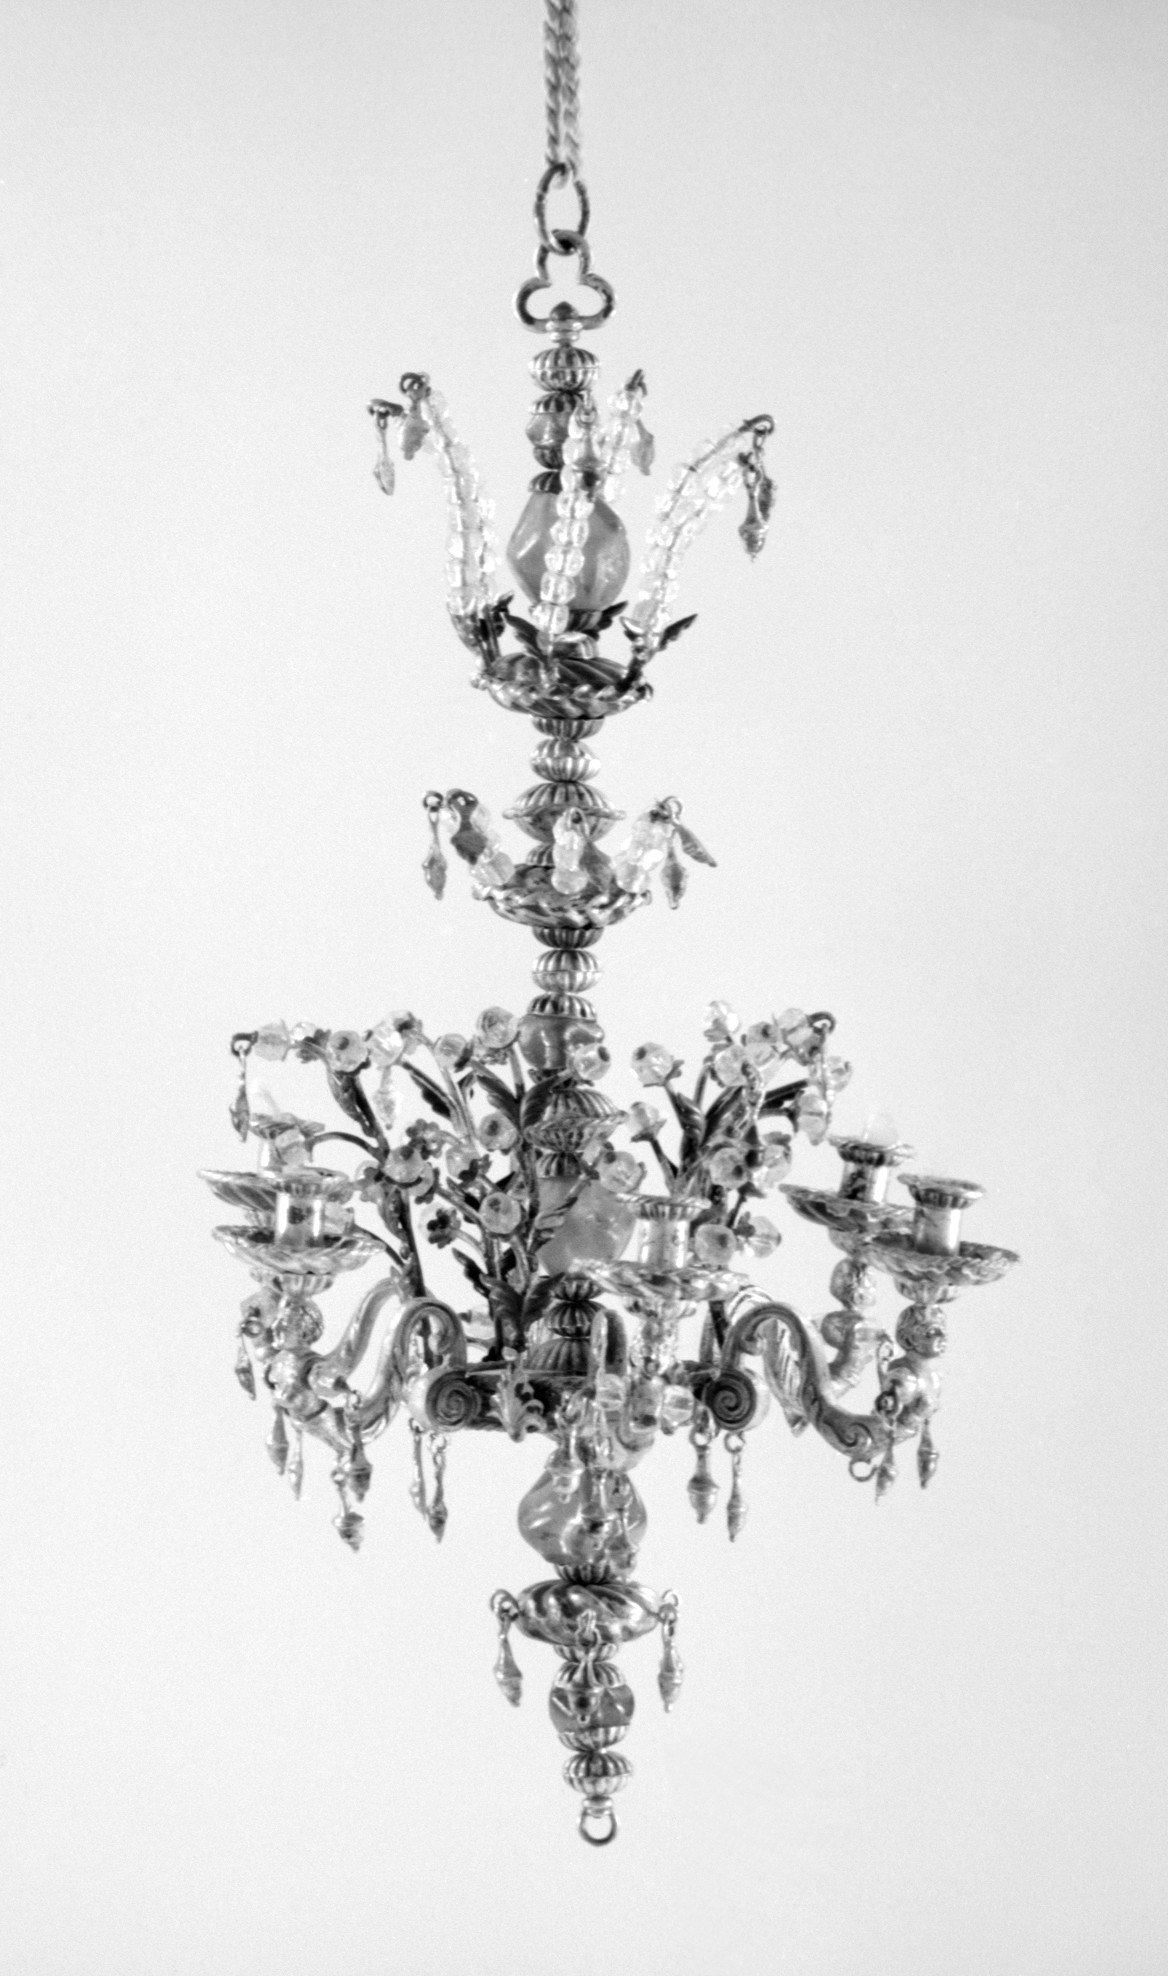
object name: chandelier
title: Miniature chandelier (one of a pair)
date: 1701-1733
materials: glass, gold, quartz